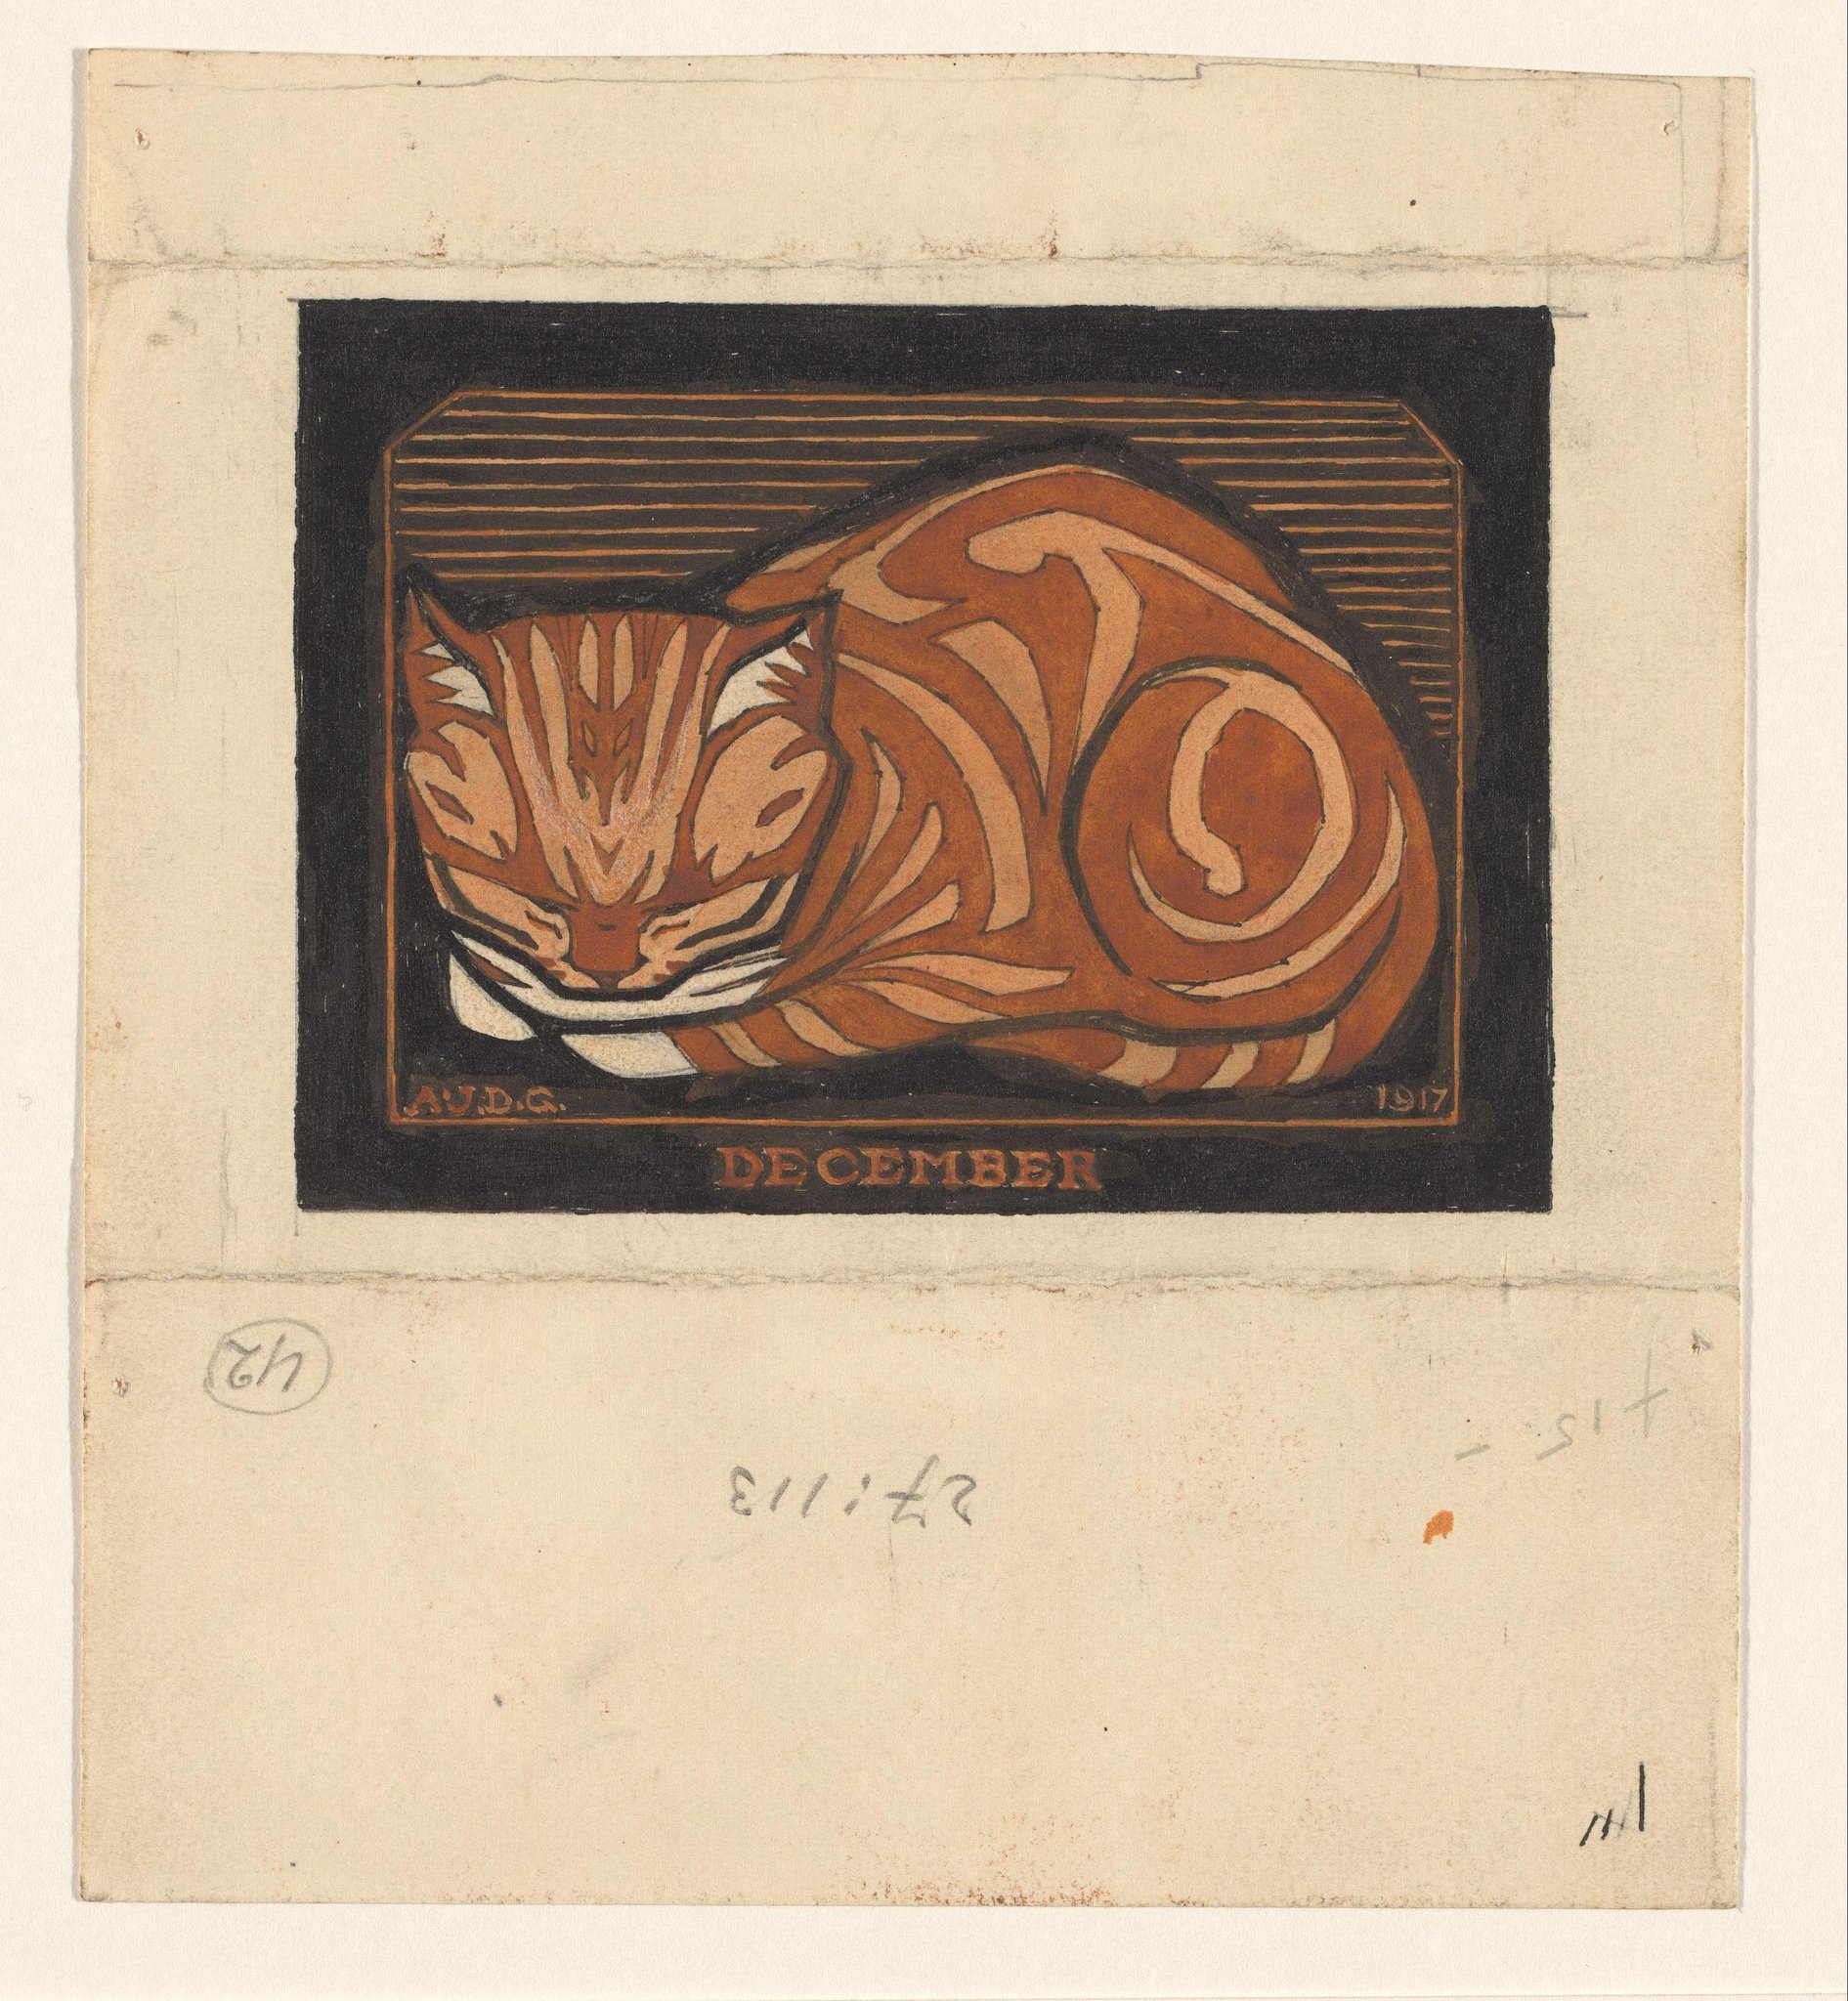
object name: drawing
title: Liggende cyperse kat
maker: julie de graag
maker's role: draughtsman, print maker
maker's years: 1877-1924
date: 1917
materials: paint, ink, paper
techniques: brush, pen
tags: cat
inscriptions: number: ‘42’, annotation: ‘f 15.-’